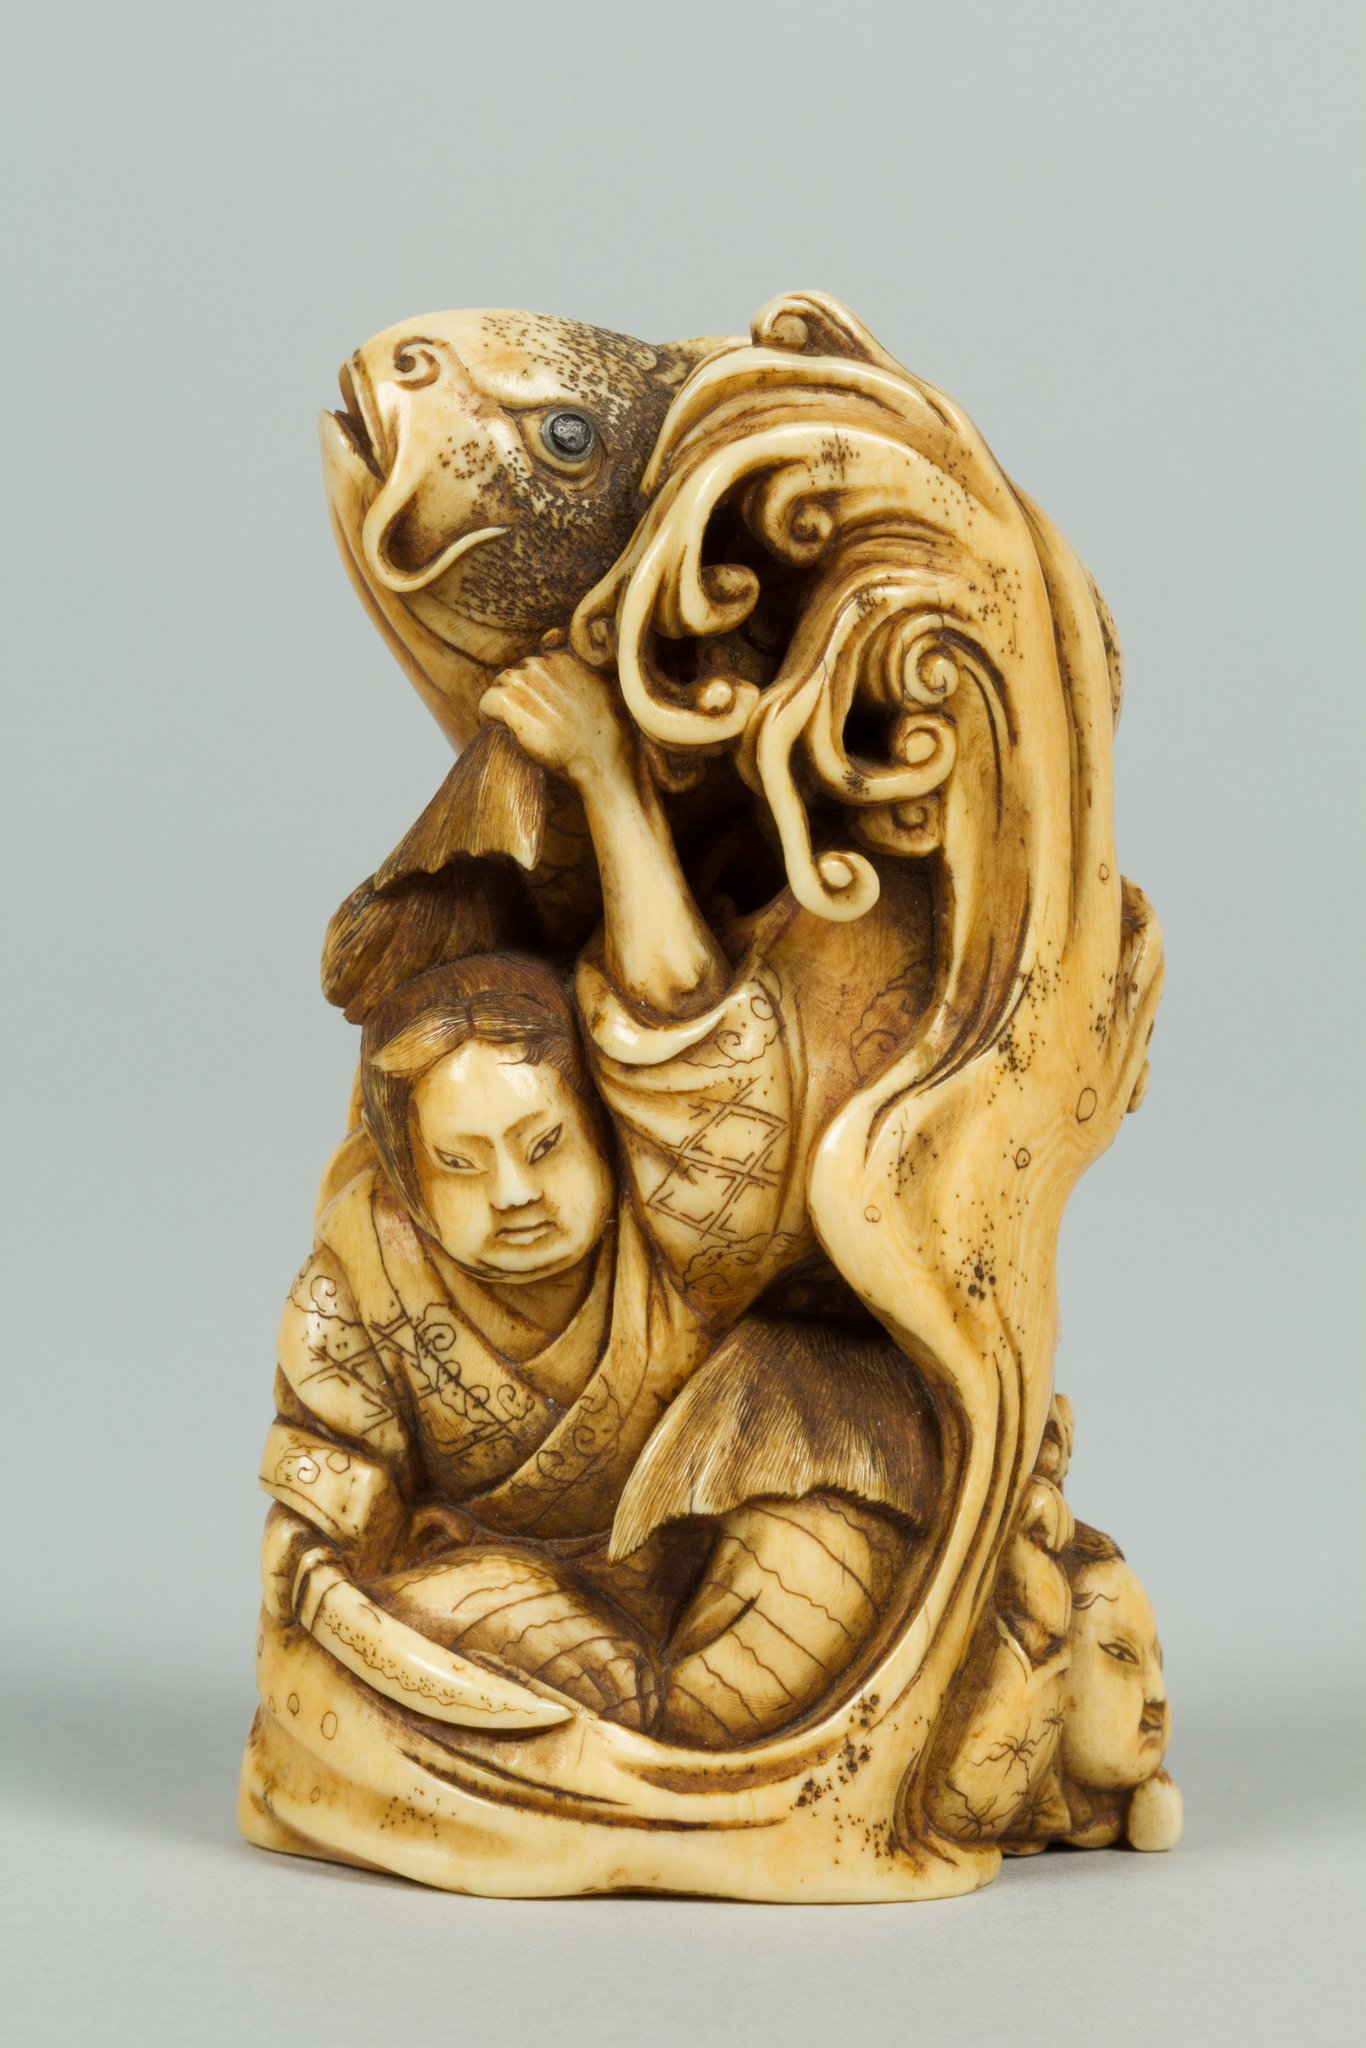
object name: netsuke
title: Netsuke of Group of men in the Water holding a Large Carp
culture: japanese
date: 1801-1900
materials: ivory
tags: men,fish